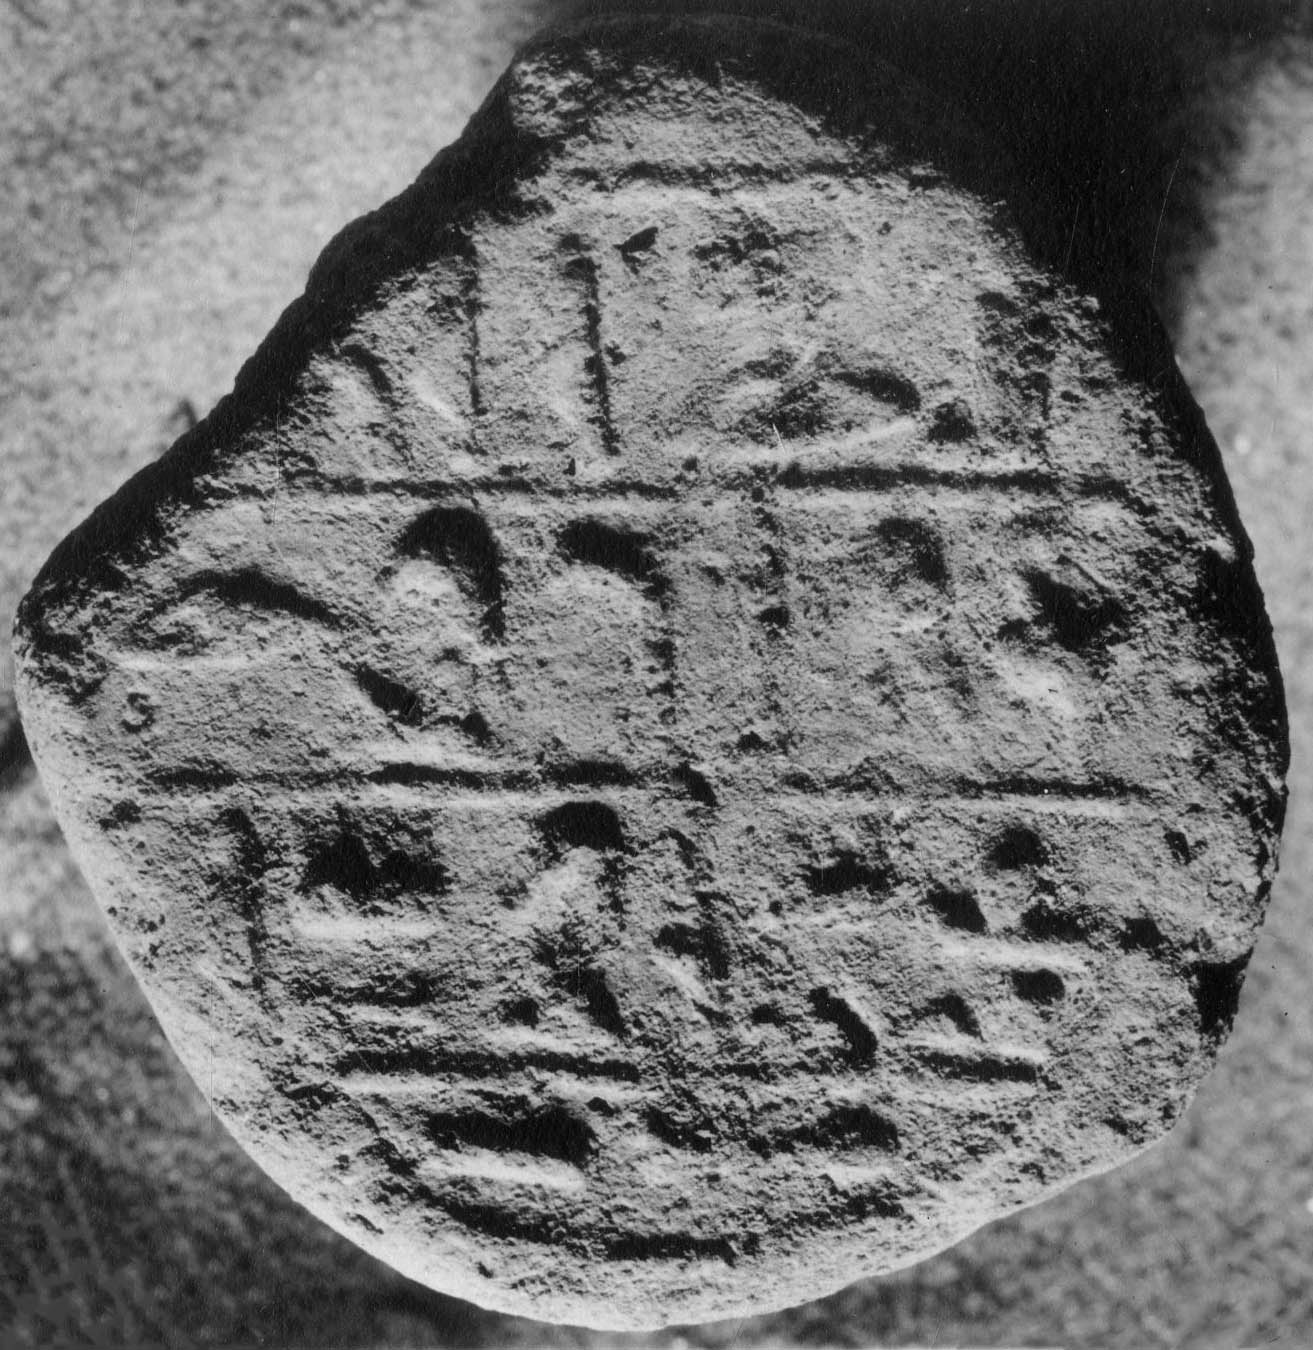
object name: cone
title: Funerary Cone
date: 1550-1295 BCE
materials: pottery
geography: egypt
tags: hieroglyphs